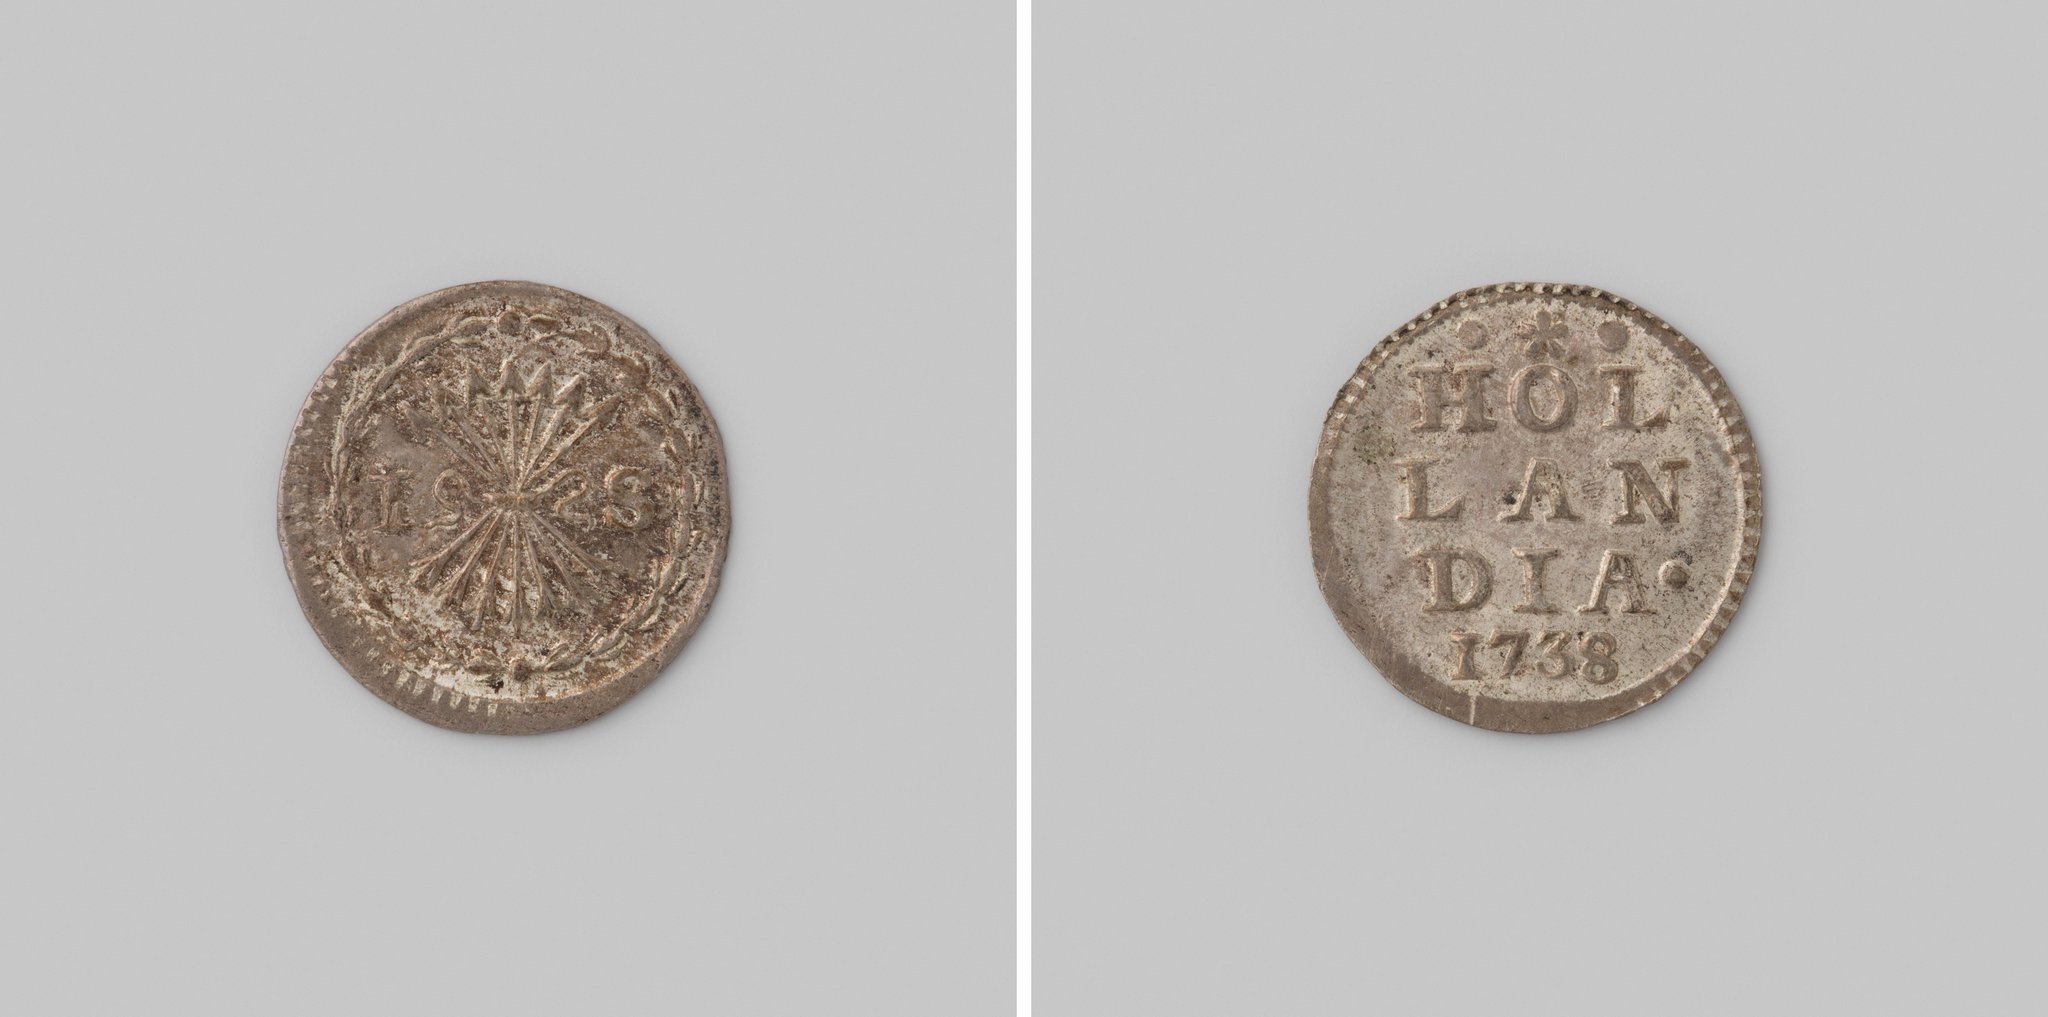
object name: coin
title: Hollandse bezemstuiver, 1738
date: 1738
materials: silver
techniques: striking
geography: dordrecht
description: Zilveren munt. Voorzijde: binnen krans tussen waarde-aanduiding pijlenbundel. Keerzijde: opschrift: provincienaam in drie regels, daaronder jaartal.